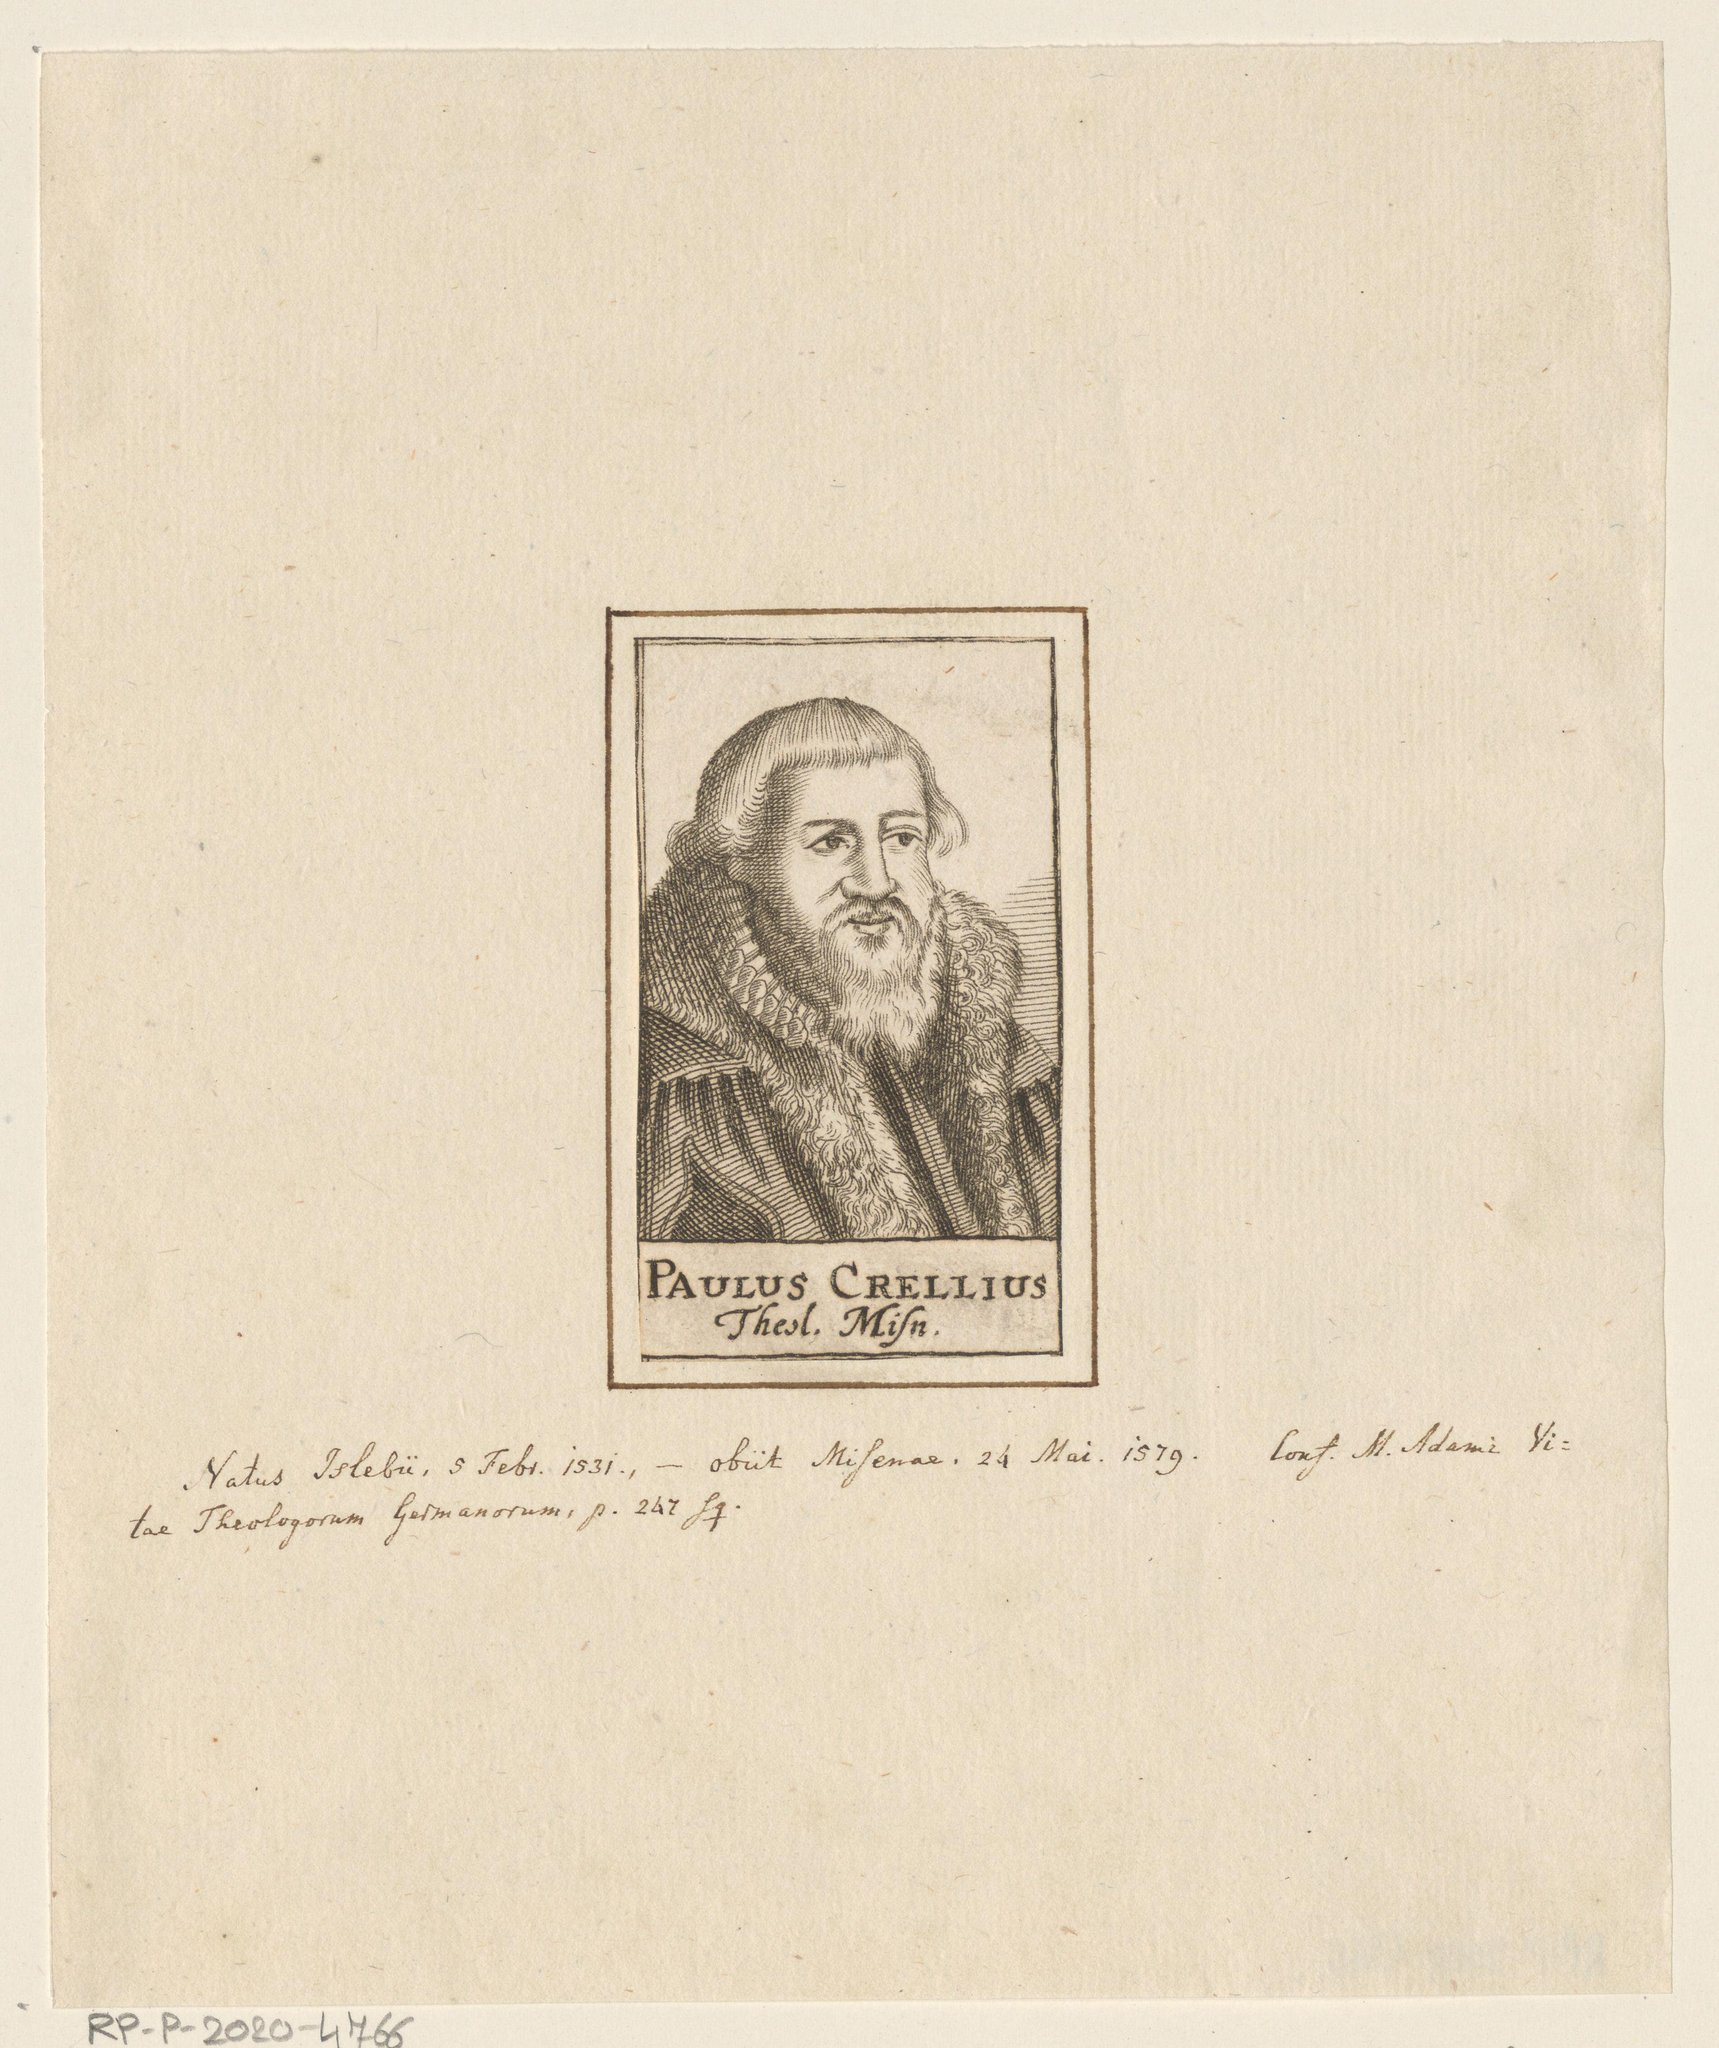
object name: print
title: Portret van Paul Crell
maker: Anonymous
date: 1688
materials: paper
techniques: engraving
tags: historical persons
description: Prent maakt deel uit van een grotere prent die later is verknipt. Prent waarschijnlijk uit: Freher, Paul. Theatrum virorum eruditione clarorum. Neurenberg: Johann Hoffmann, 1688.